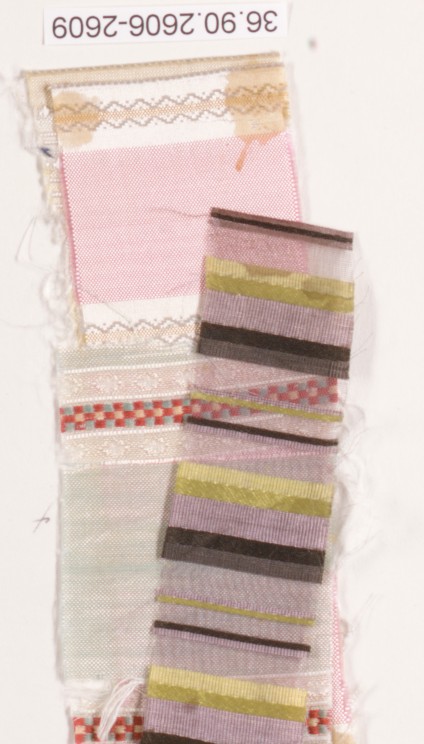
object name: ribbon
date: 1801-1900